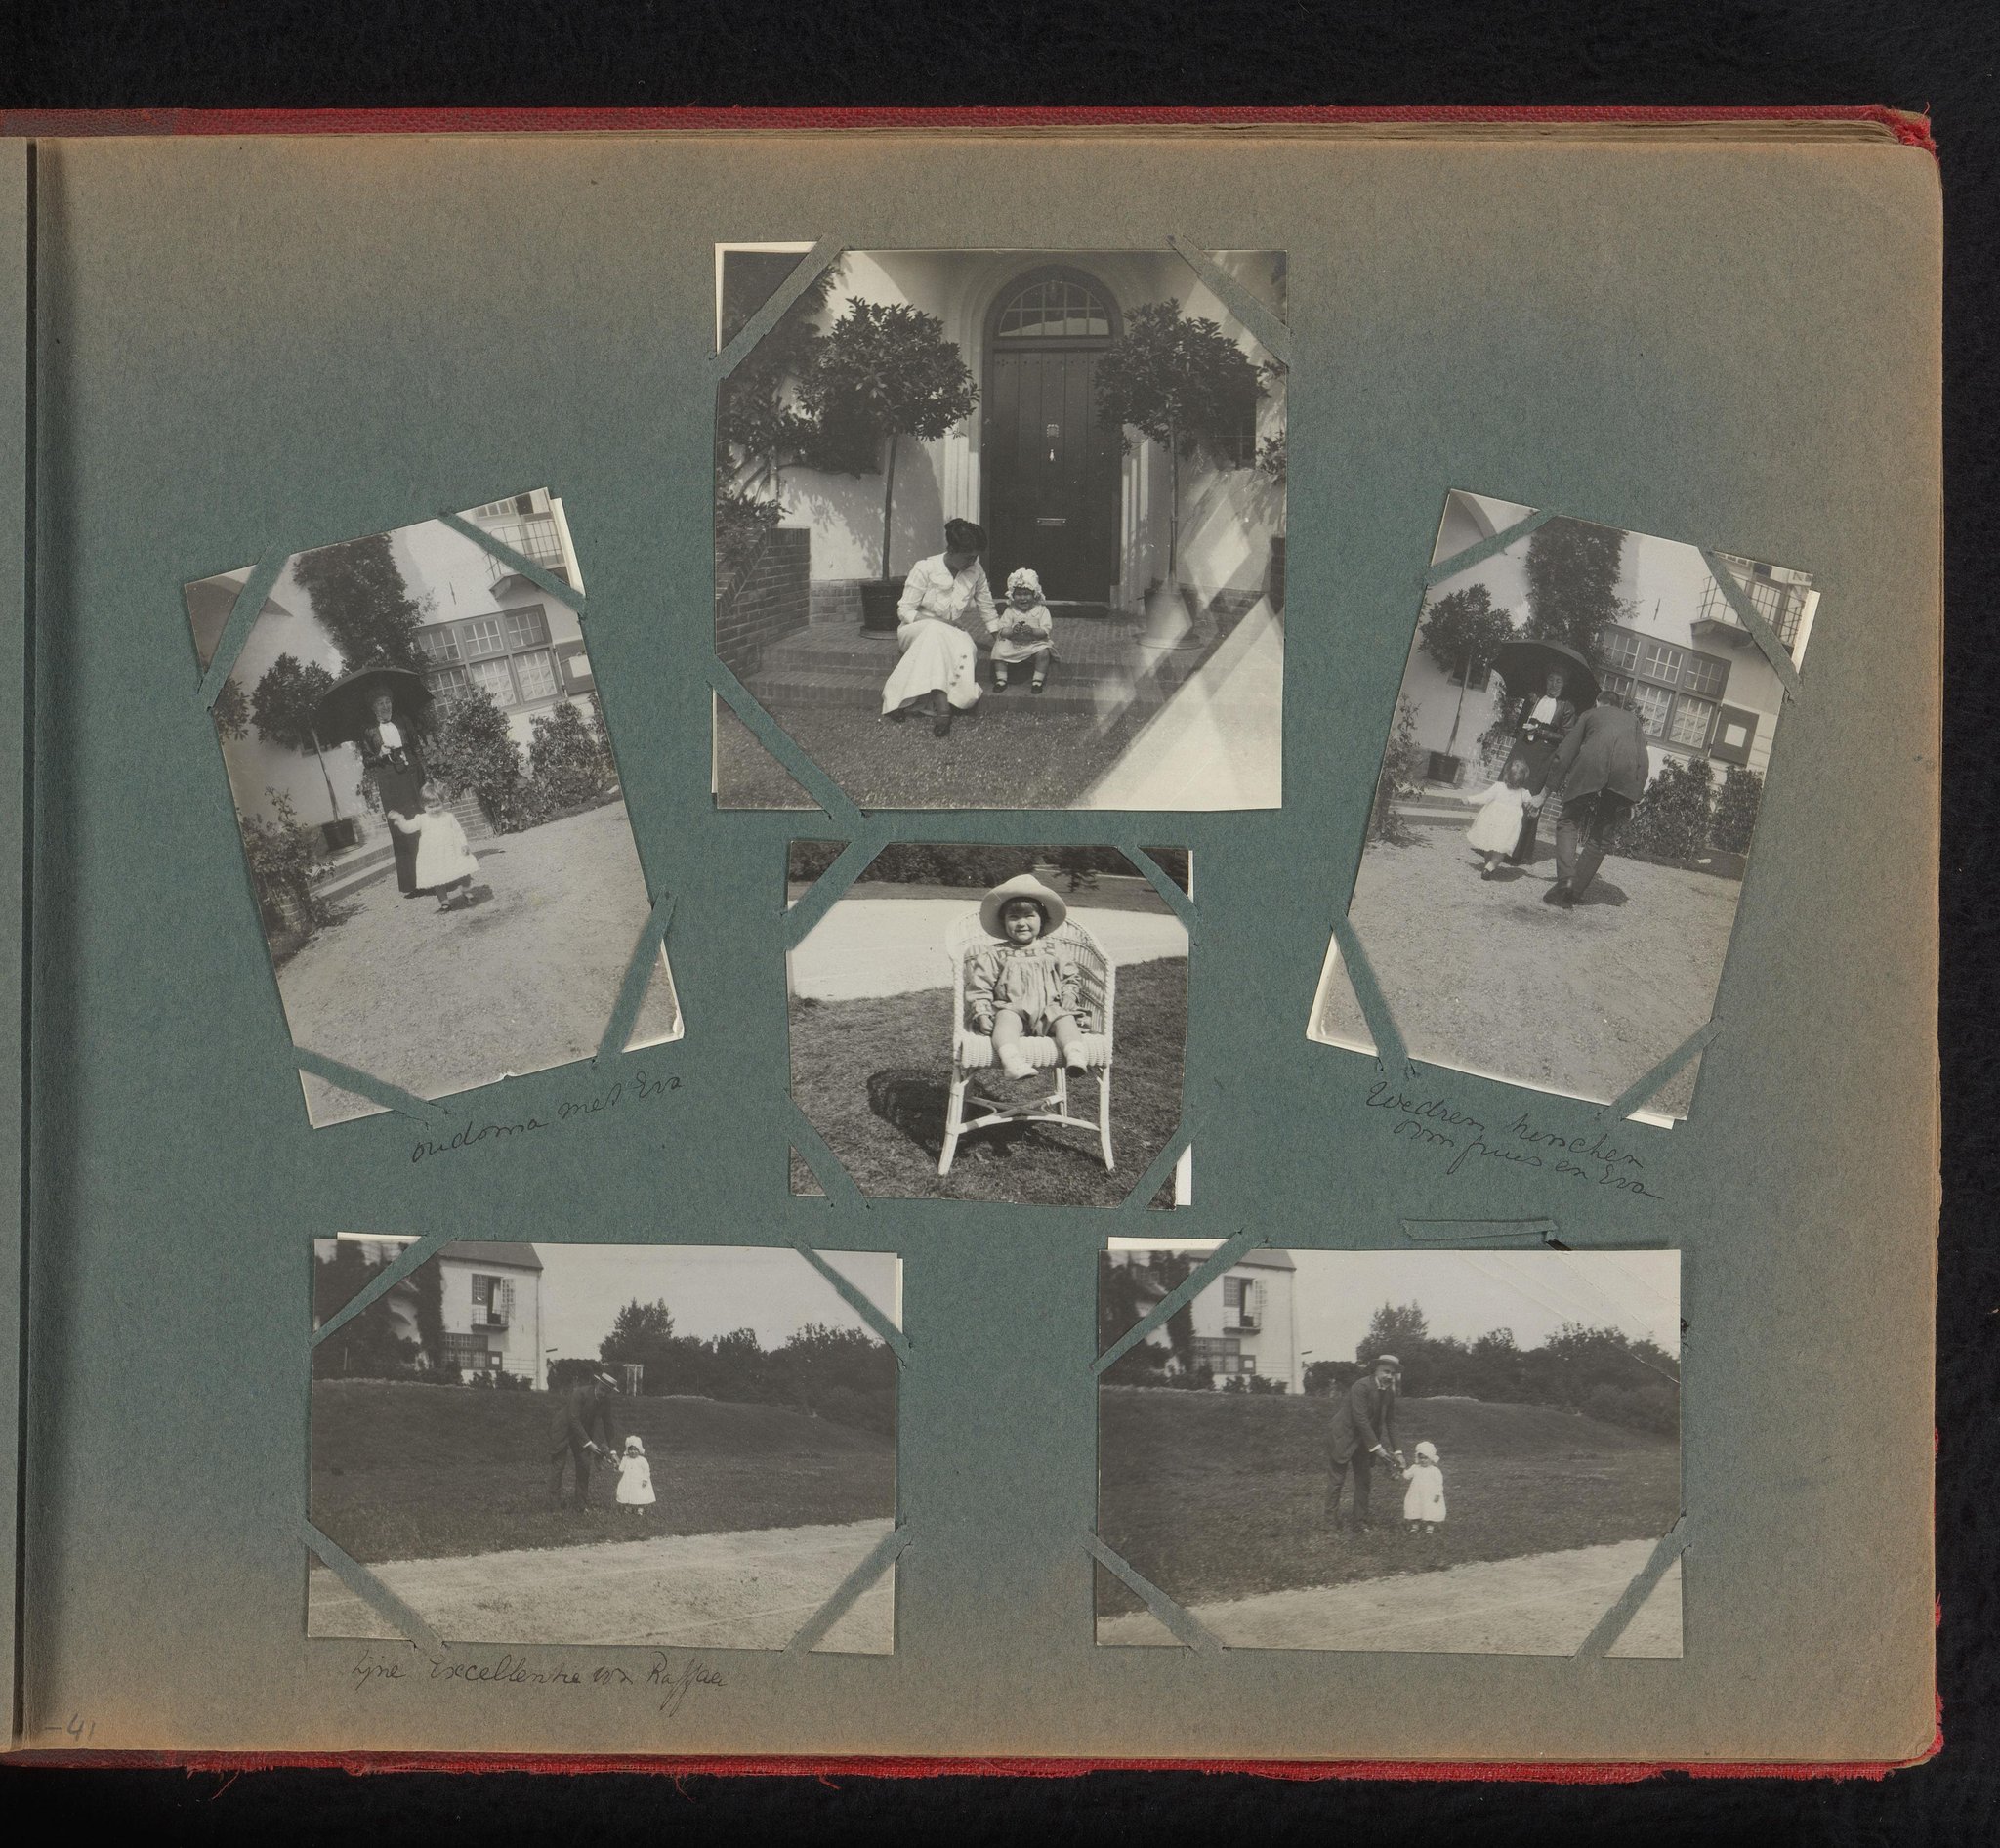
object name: album leaf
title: Zes taferelen met Eva en Charlotte Boelen, en Charlotte Matthes-Doorman, bij Huis Sonnevanck in Aerdenhout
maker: charlotte alida boelen-matthes (lot)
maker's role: amateurfotograaf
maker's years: 1889-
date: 1913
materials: paper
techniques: gelatin silver print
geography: aerdenhout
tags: eva charlotte pennink-boelen, charlotte alida boelen-matthes (lot), garden, toddler (female)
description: Deze foto's zijn onderdeel van een album.